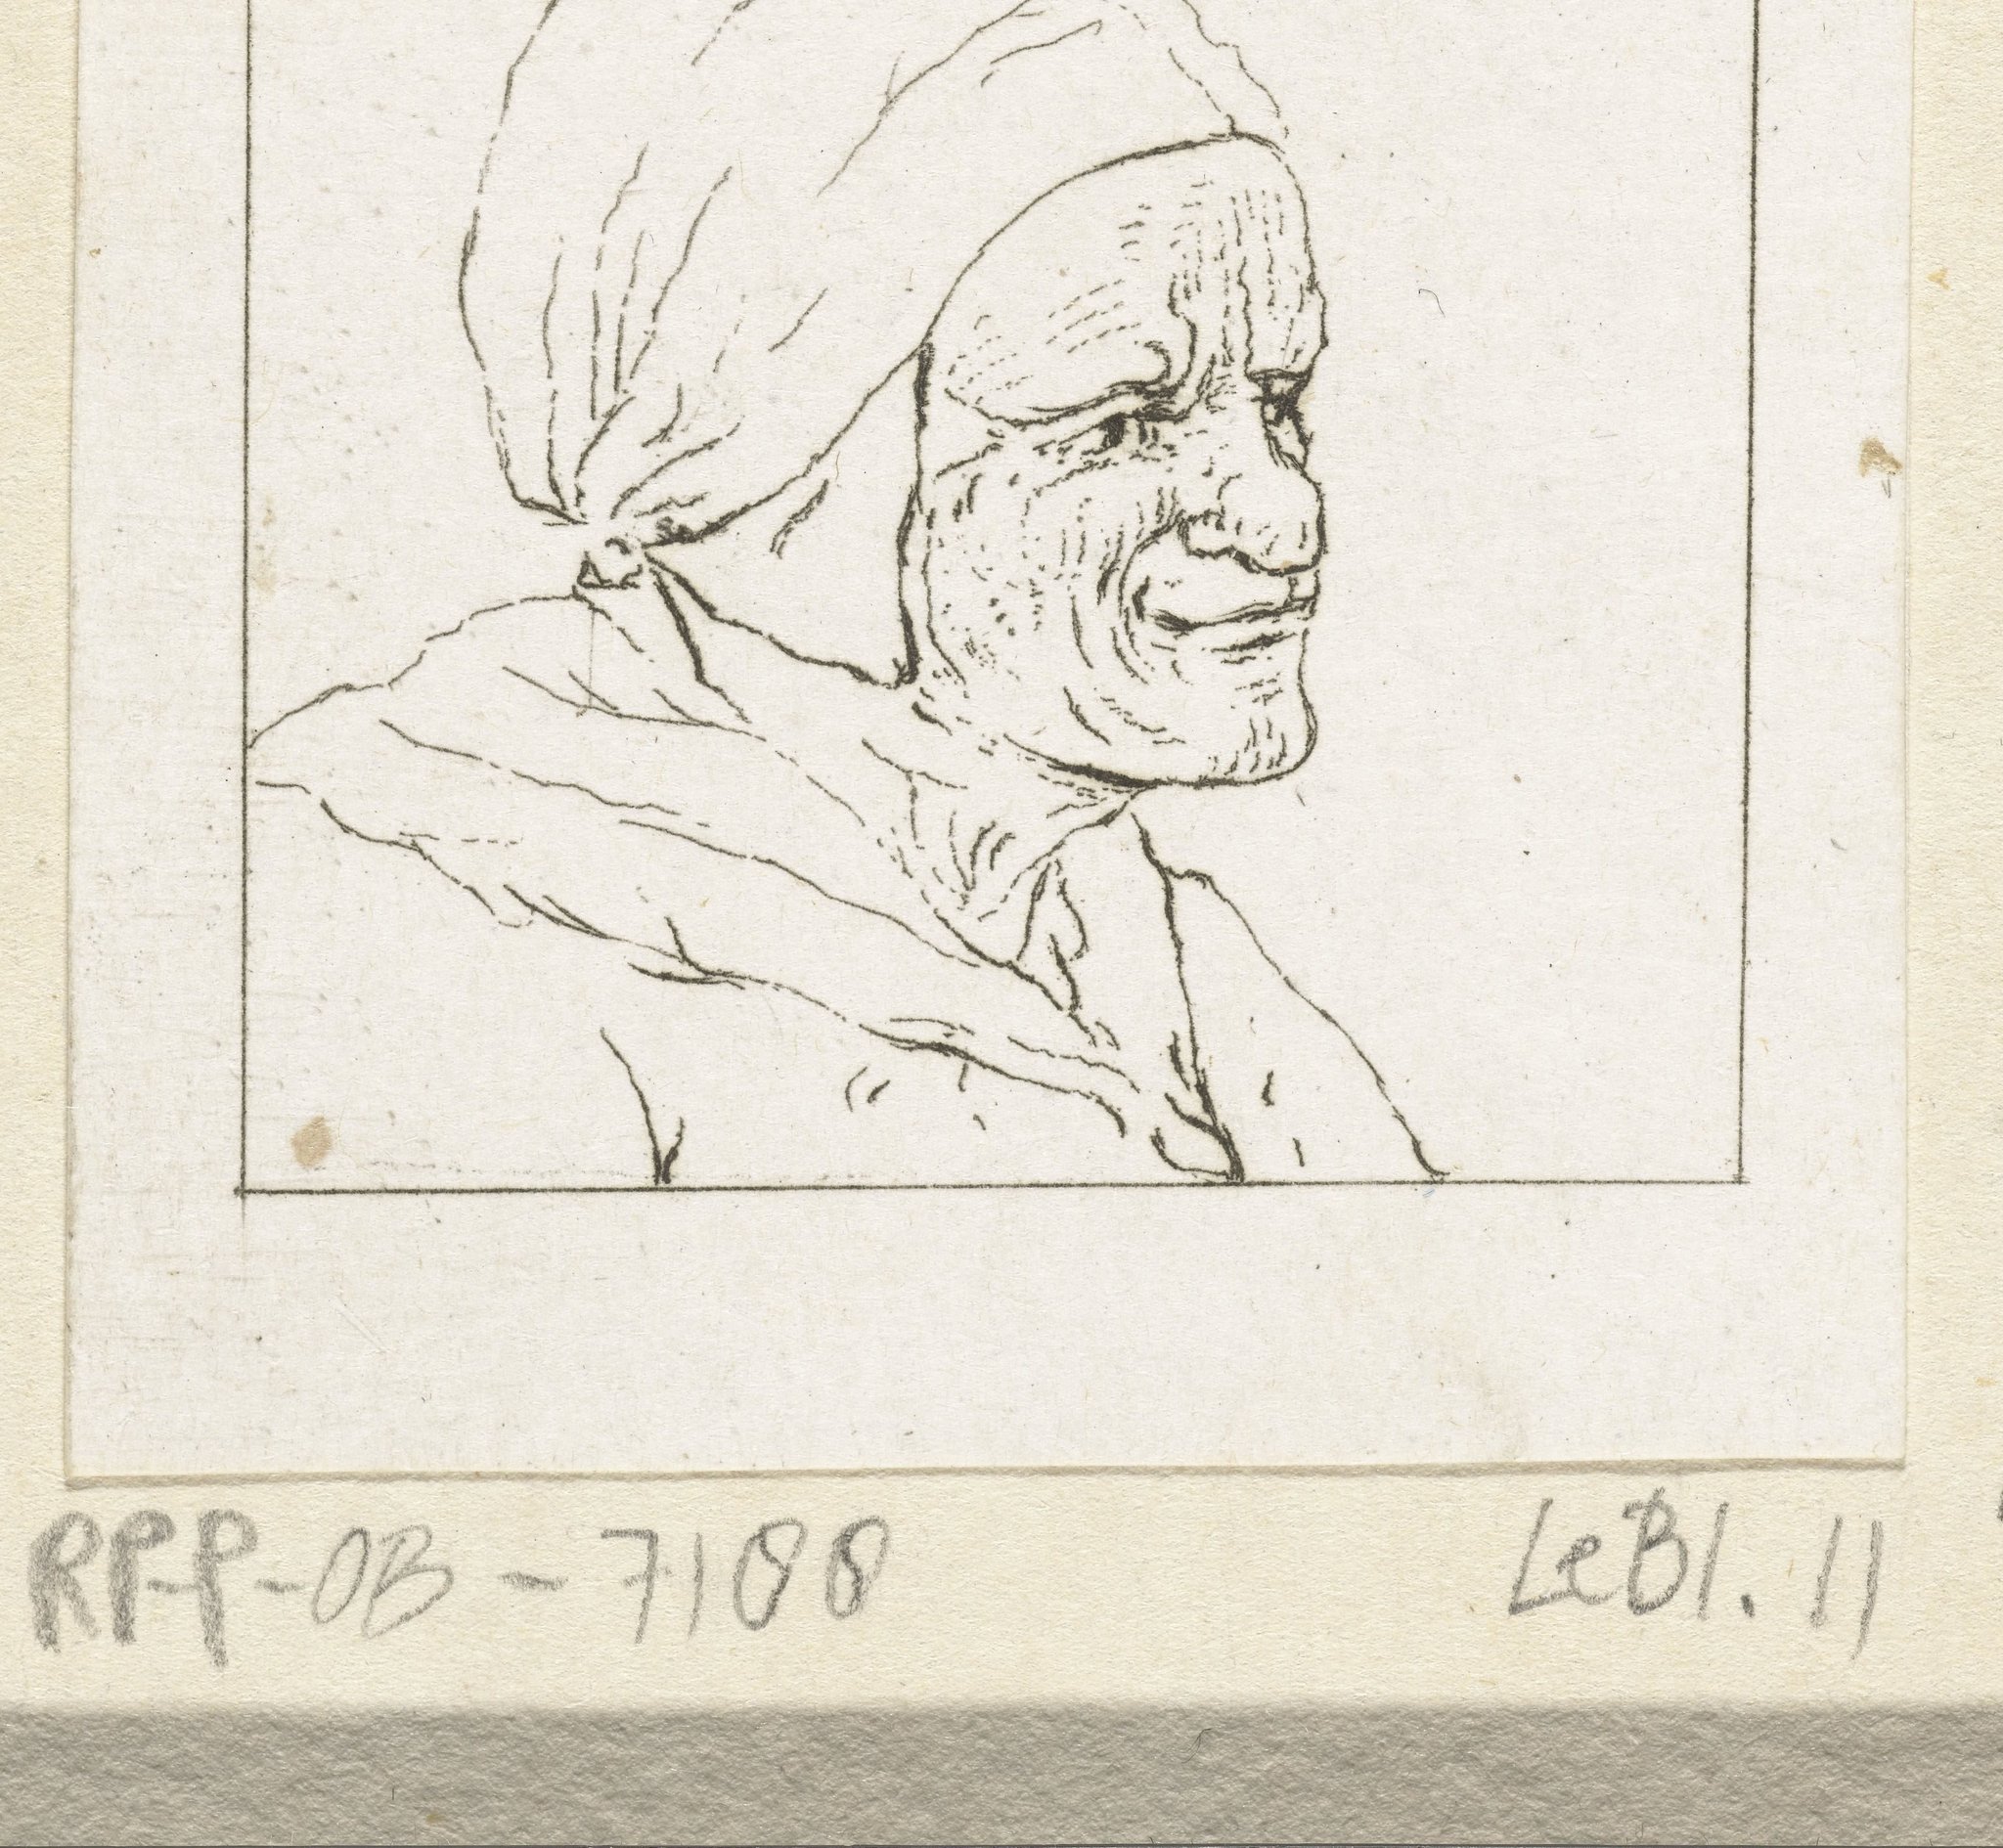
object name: print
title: Kop van een oude vrouw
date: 1779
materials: paper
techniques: etching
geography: leiden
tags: farmers - aa - female farmer, farmer's wife, morphology of human expression (+ old female (human being))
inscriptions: collector's mark: Lugt 2228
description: De buste van een oude boerin. Buste naar rechts. Ze draagt een wit kapje.